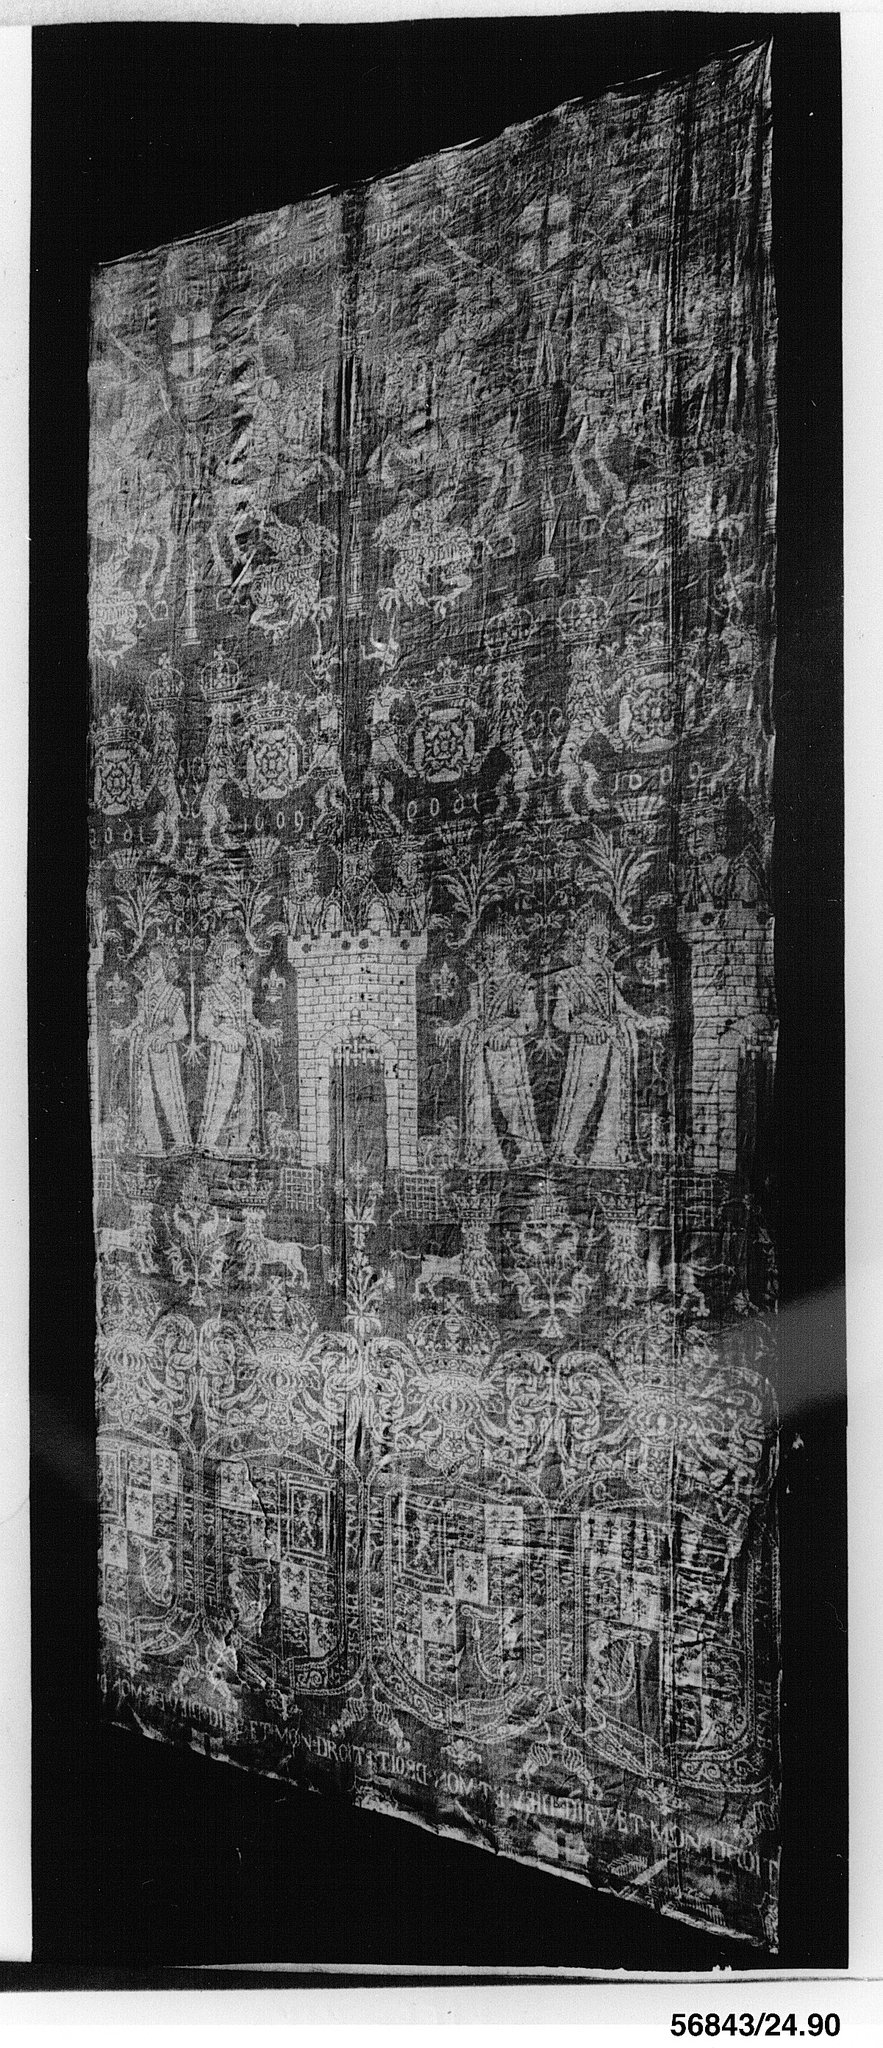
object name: tablecloth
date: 1609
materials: linen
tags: men,lions,coat of arms